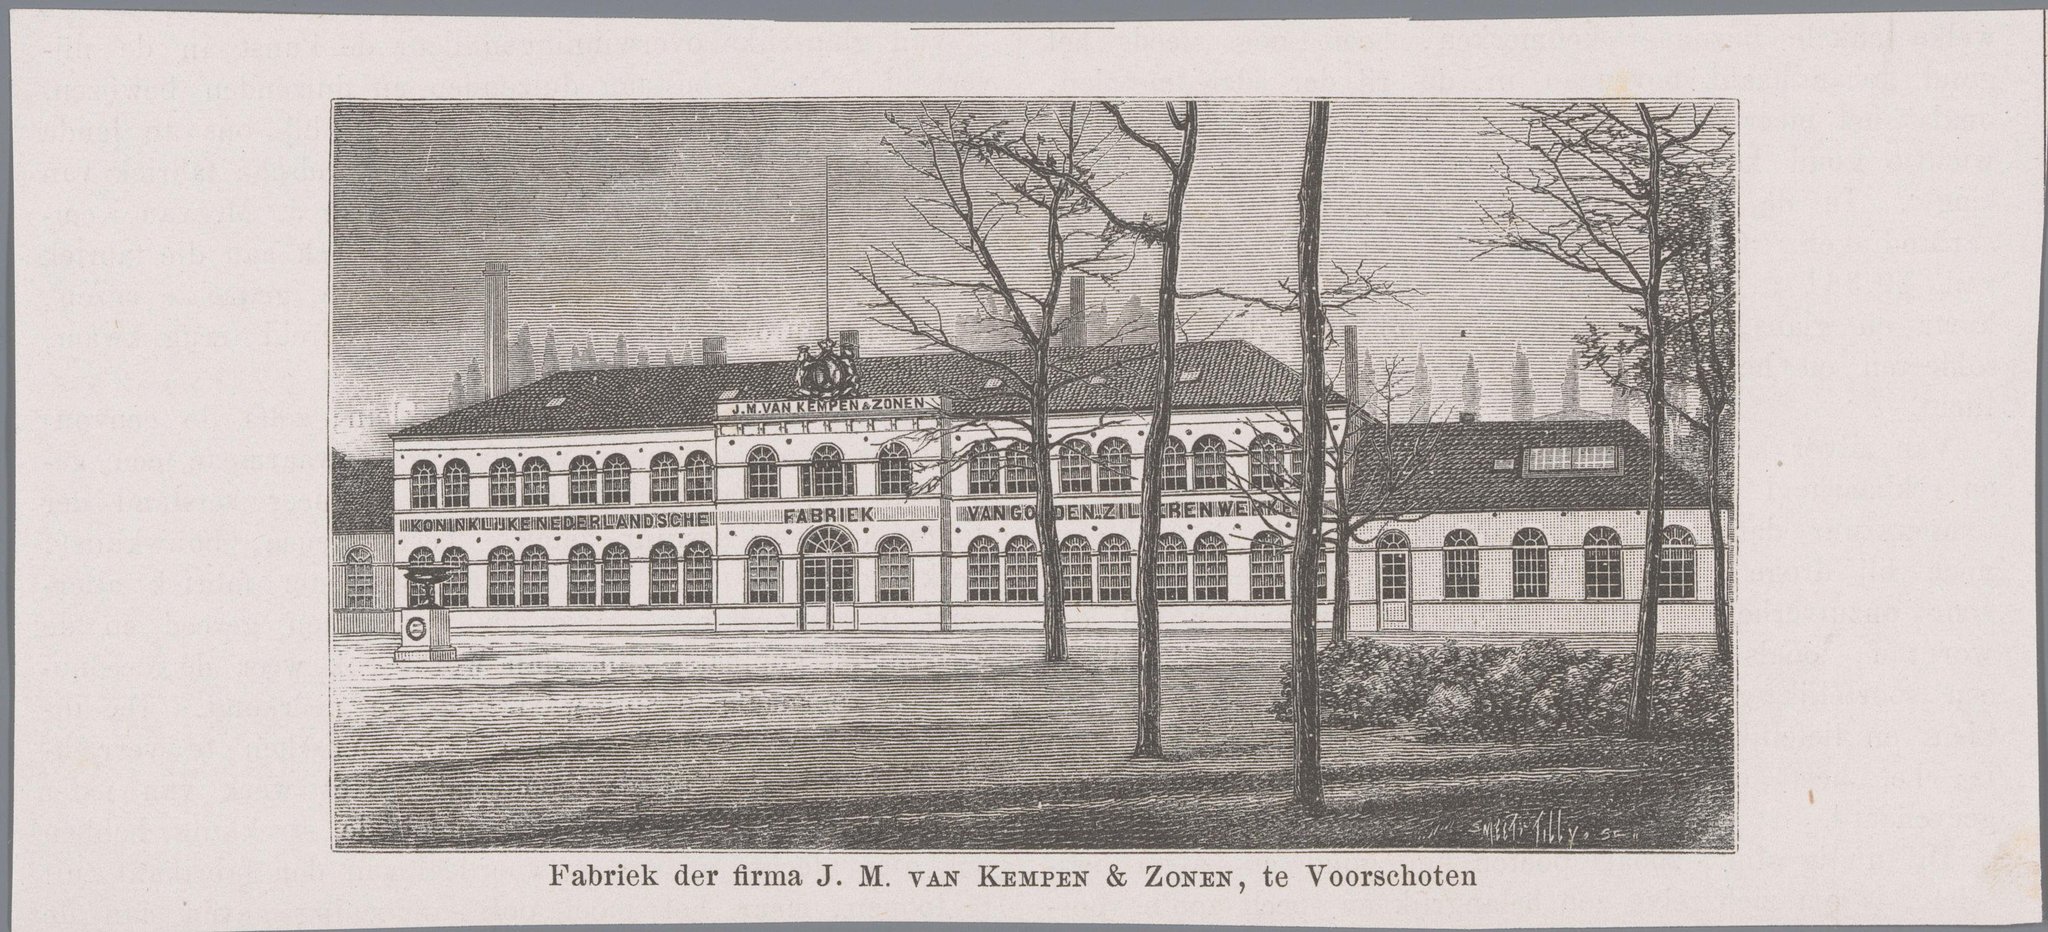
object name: print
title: Fabriek der firma J.M. van Kempen & Zonen, te Voorschoten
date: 1880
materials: paper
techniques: letterpress printing, engraving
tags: factory-building, voorschoten